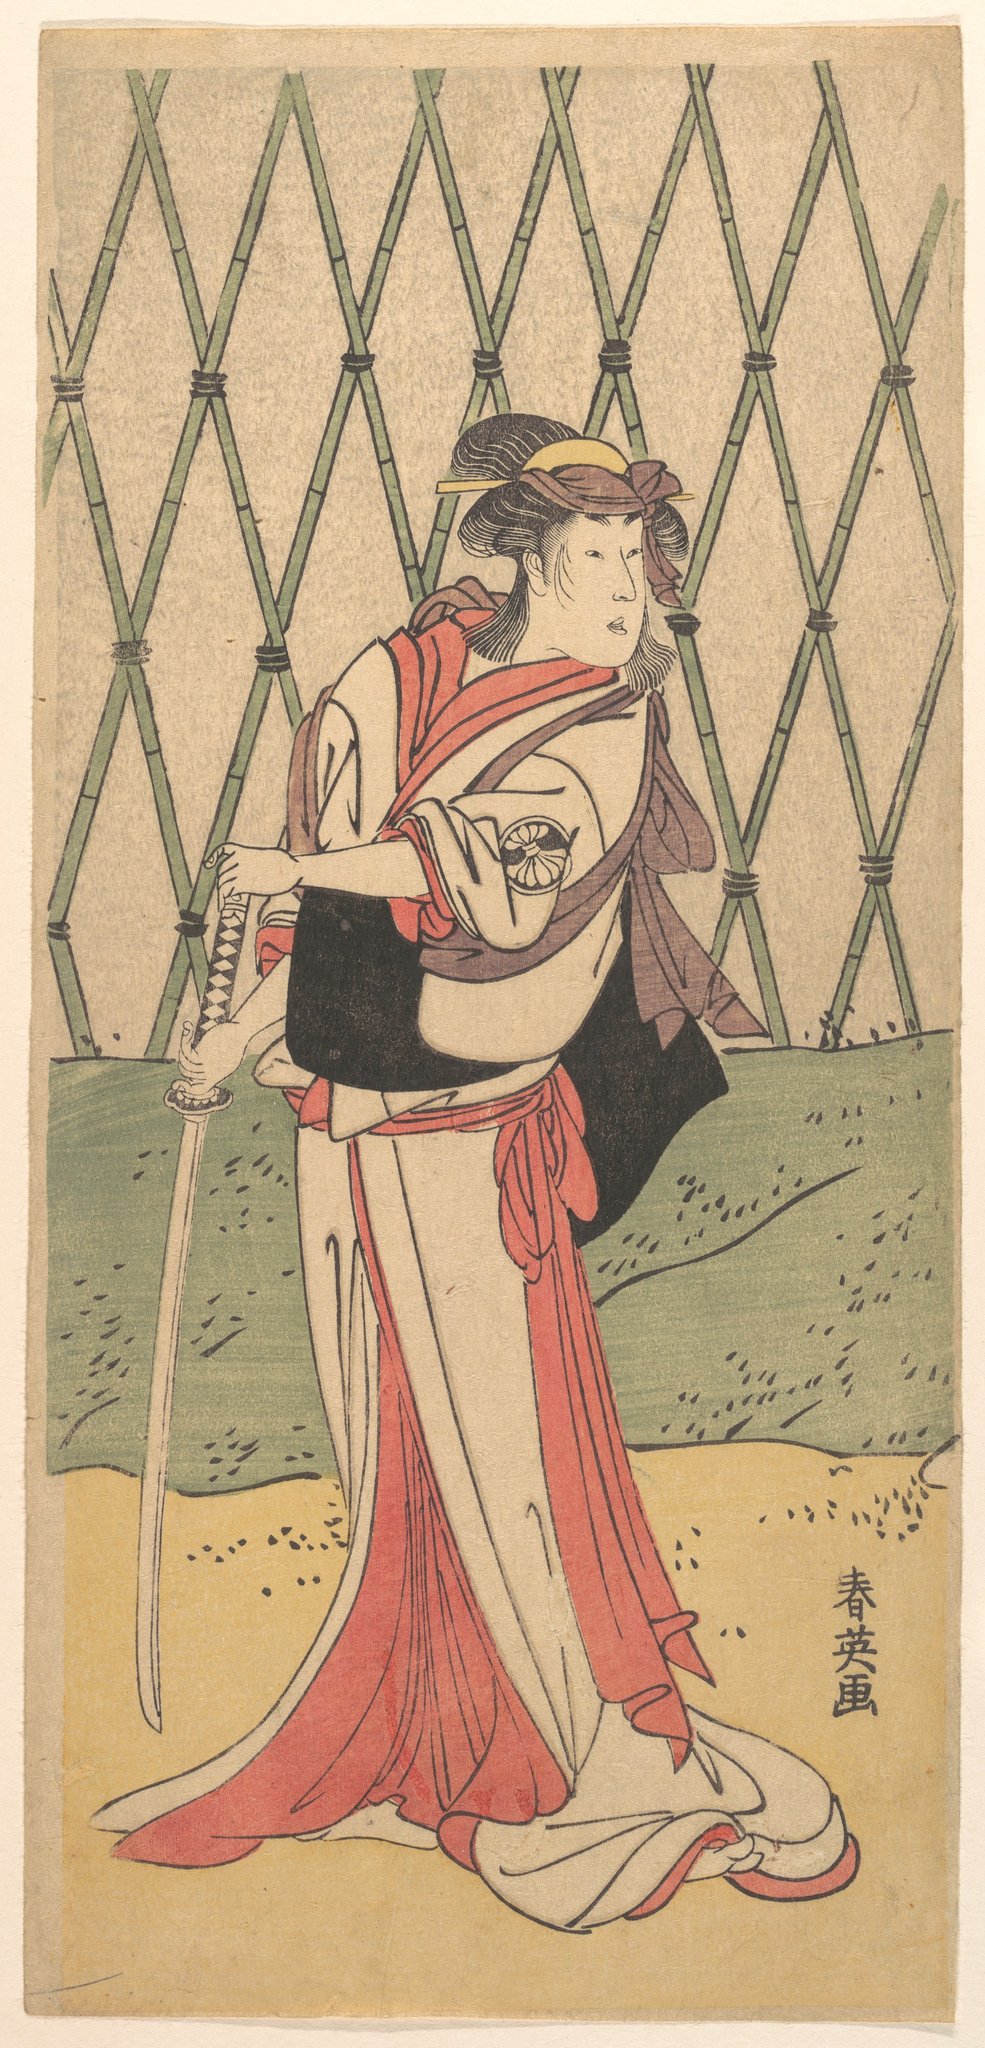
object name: print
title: Segawa Kikunojo, in a Female Role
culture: japanese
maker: katsukawa shun'ei 勝川春英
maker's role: artist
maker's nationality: japanese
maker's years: 1762-1819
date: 1762-1819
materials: ink, paper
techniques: woodblock print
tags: swords,actors